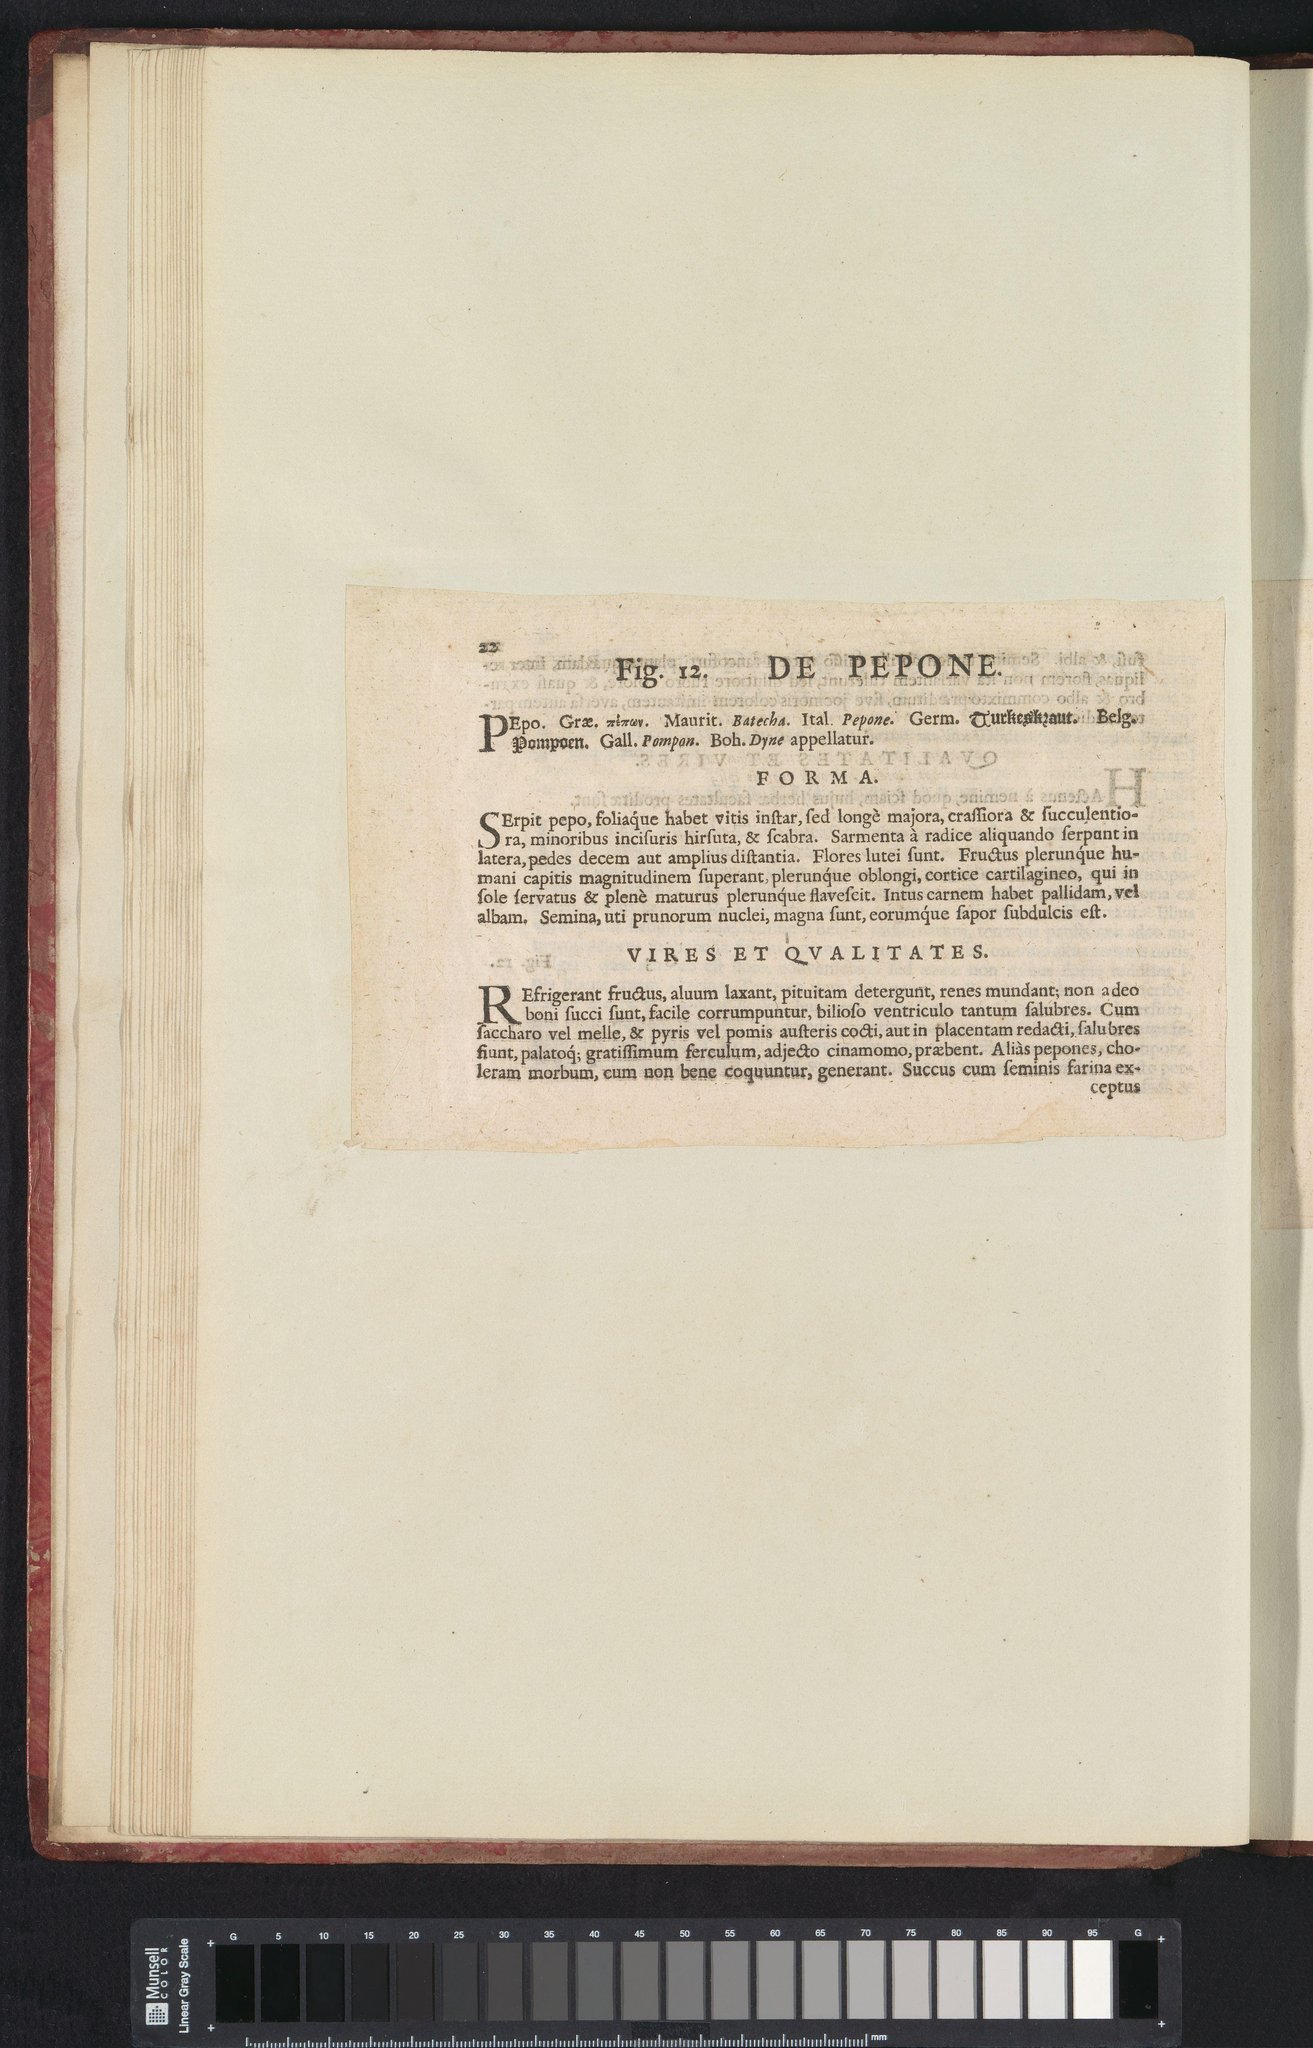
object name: text sheet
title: Fig. 12 'De Pepone' in De Boodts herbarium van 1640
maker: anselmus boëtius de boodt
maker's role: draughtsman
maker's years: 1550-1632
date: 1640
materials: ink, paper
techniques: letterpress printing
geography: bruges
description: Beschrijving bij Fig. 12 op p. 22 in: Anselmi Boëtii de Boot I.C. Brugensis & Rodolphi II. Imp. Roman. medici a cubiculis Florum, Herbarum, ac fructuum selectiorum icones, & vires pleraeque hactenus ignotæ. Onderdeel van het album met bladen en platen uit De Boodts herbarium van 1640. Het twaalfde van twaalf albums met aquarellen van dieren, vogels en planten bekend rond 1600, gemaakt in opdracht van keizer Rudolf II.